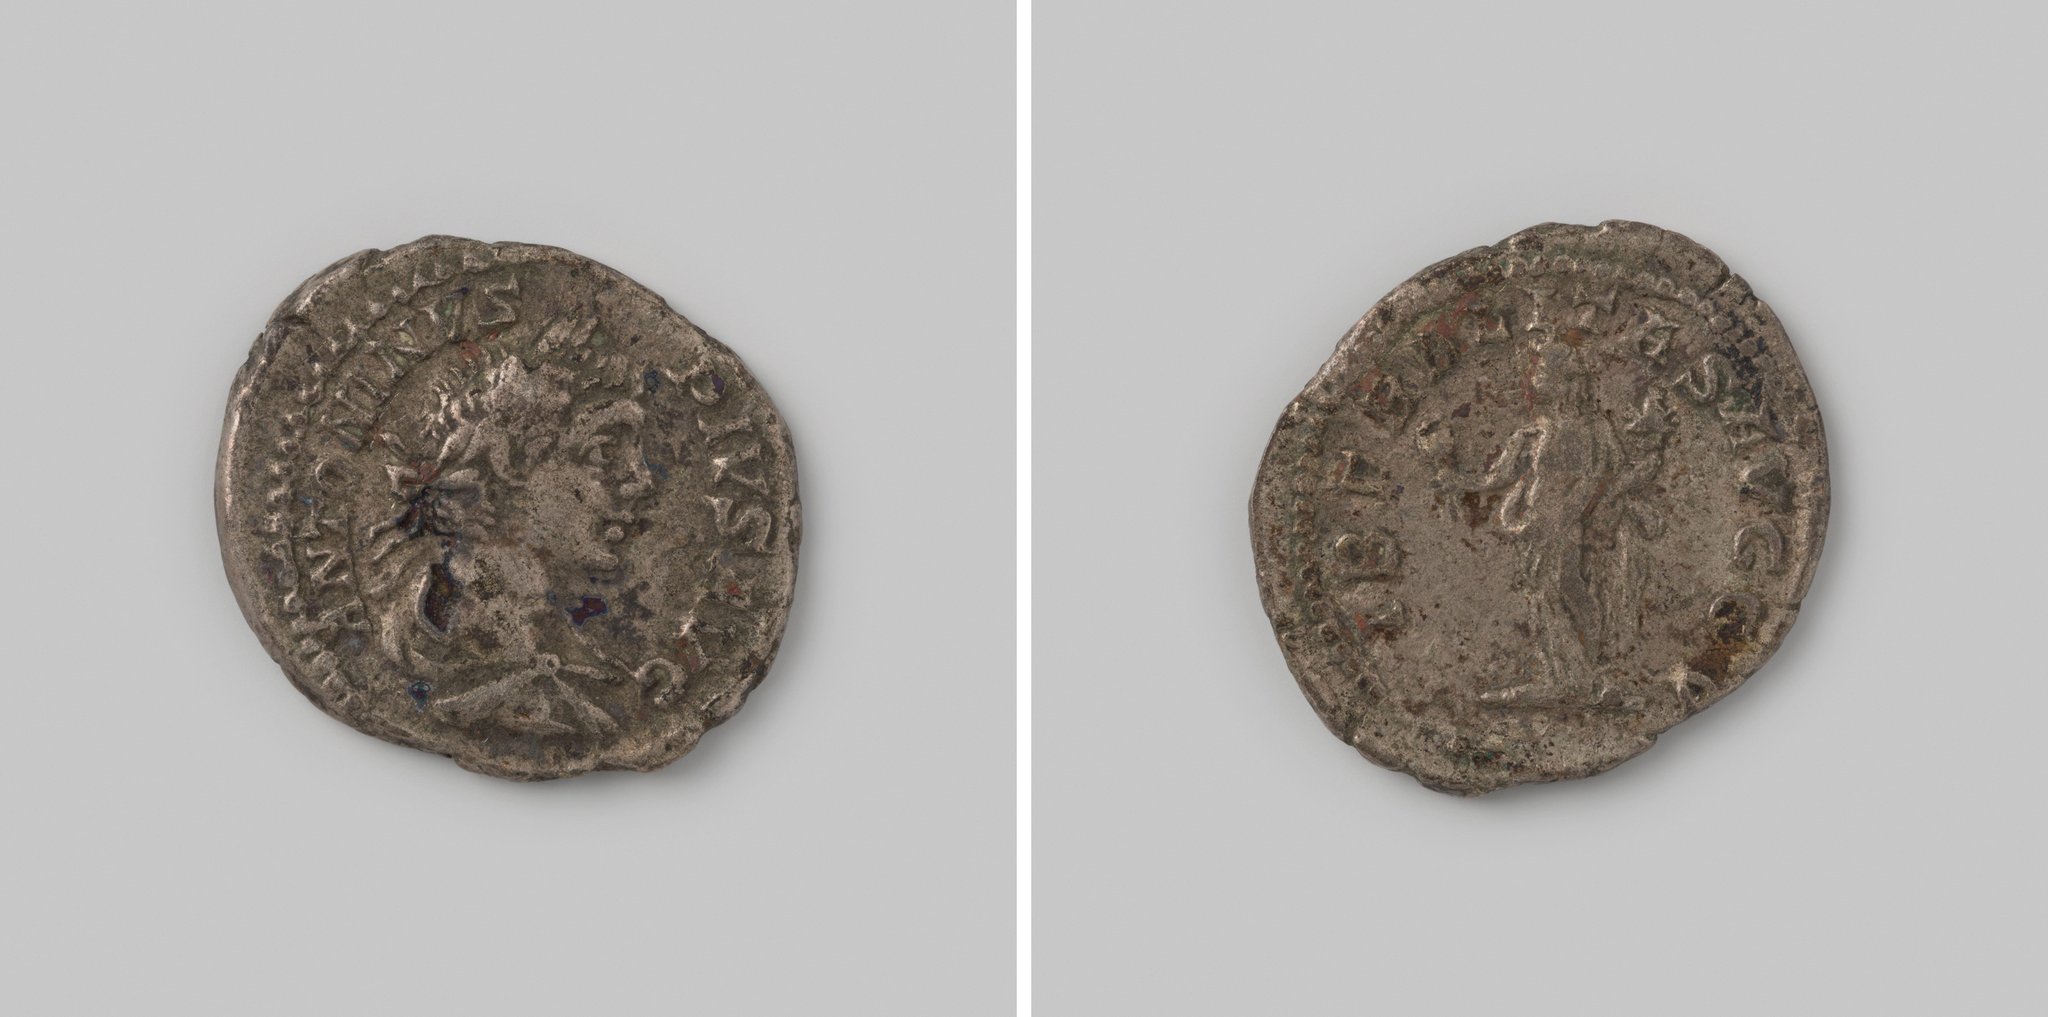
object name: denarius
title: Denarius uit het Romeinse Keizerrijk van Caracalla, 198-217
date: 198-217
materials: silver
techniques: striking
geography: rome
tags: liberalitas, caracalla (keizer van het romeinse rijk)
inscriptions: circumscription: ‘LIBERALITAS AVGG V’, circumscription: ‘ANTONINVS PIVS AVG’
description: keerzijde: de godin van de vrijgevigheid, Liberalitas, staand met in haar rechterhand een abacus en in haar linkerhand een cornucopia